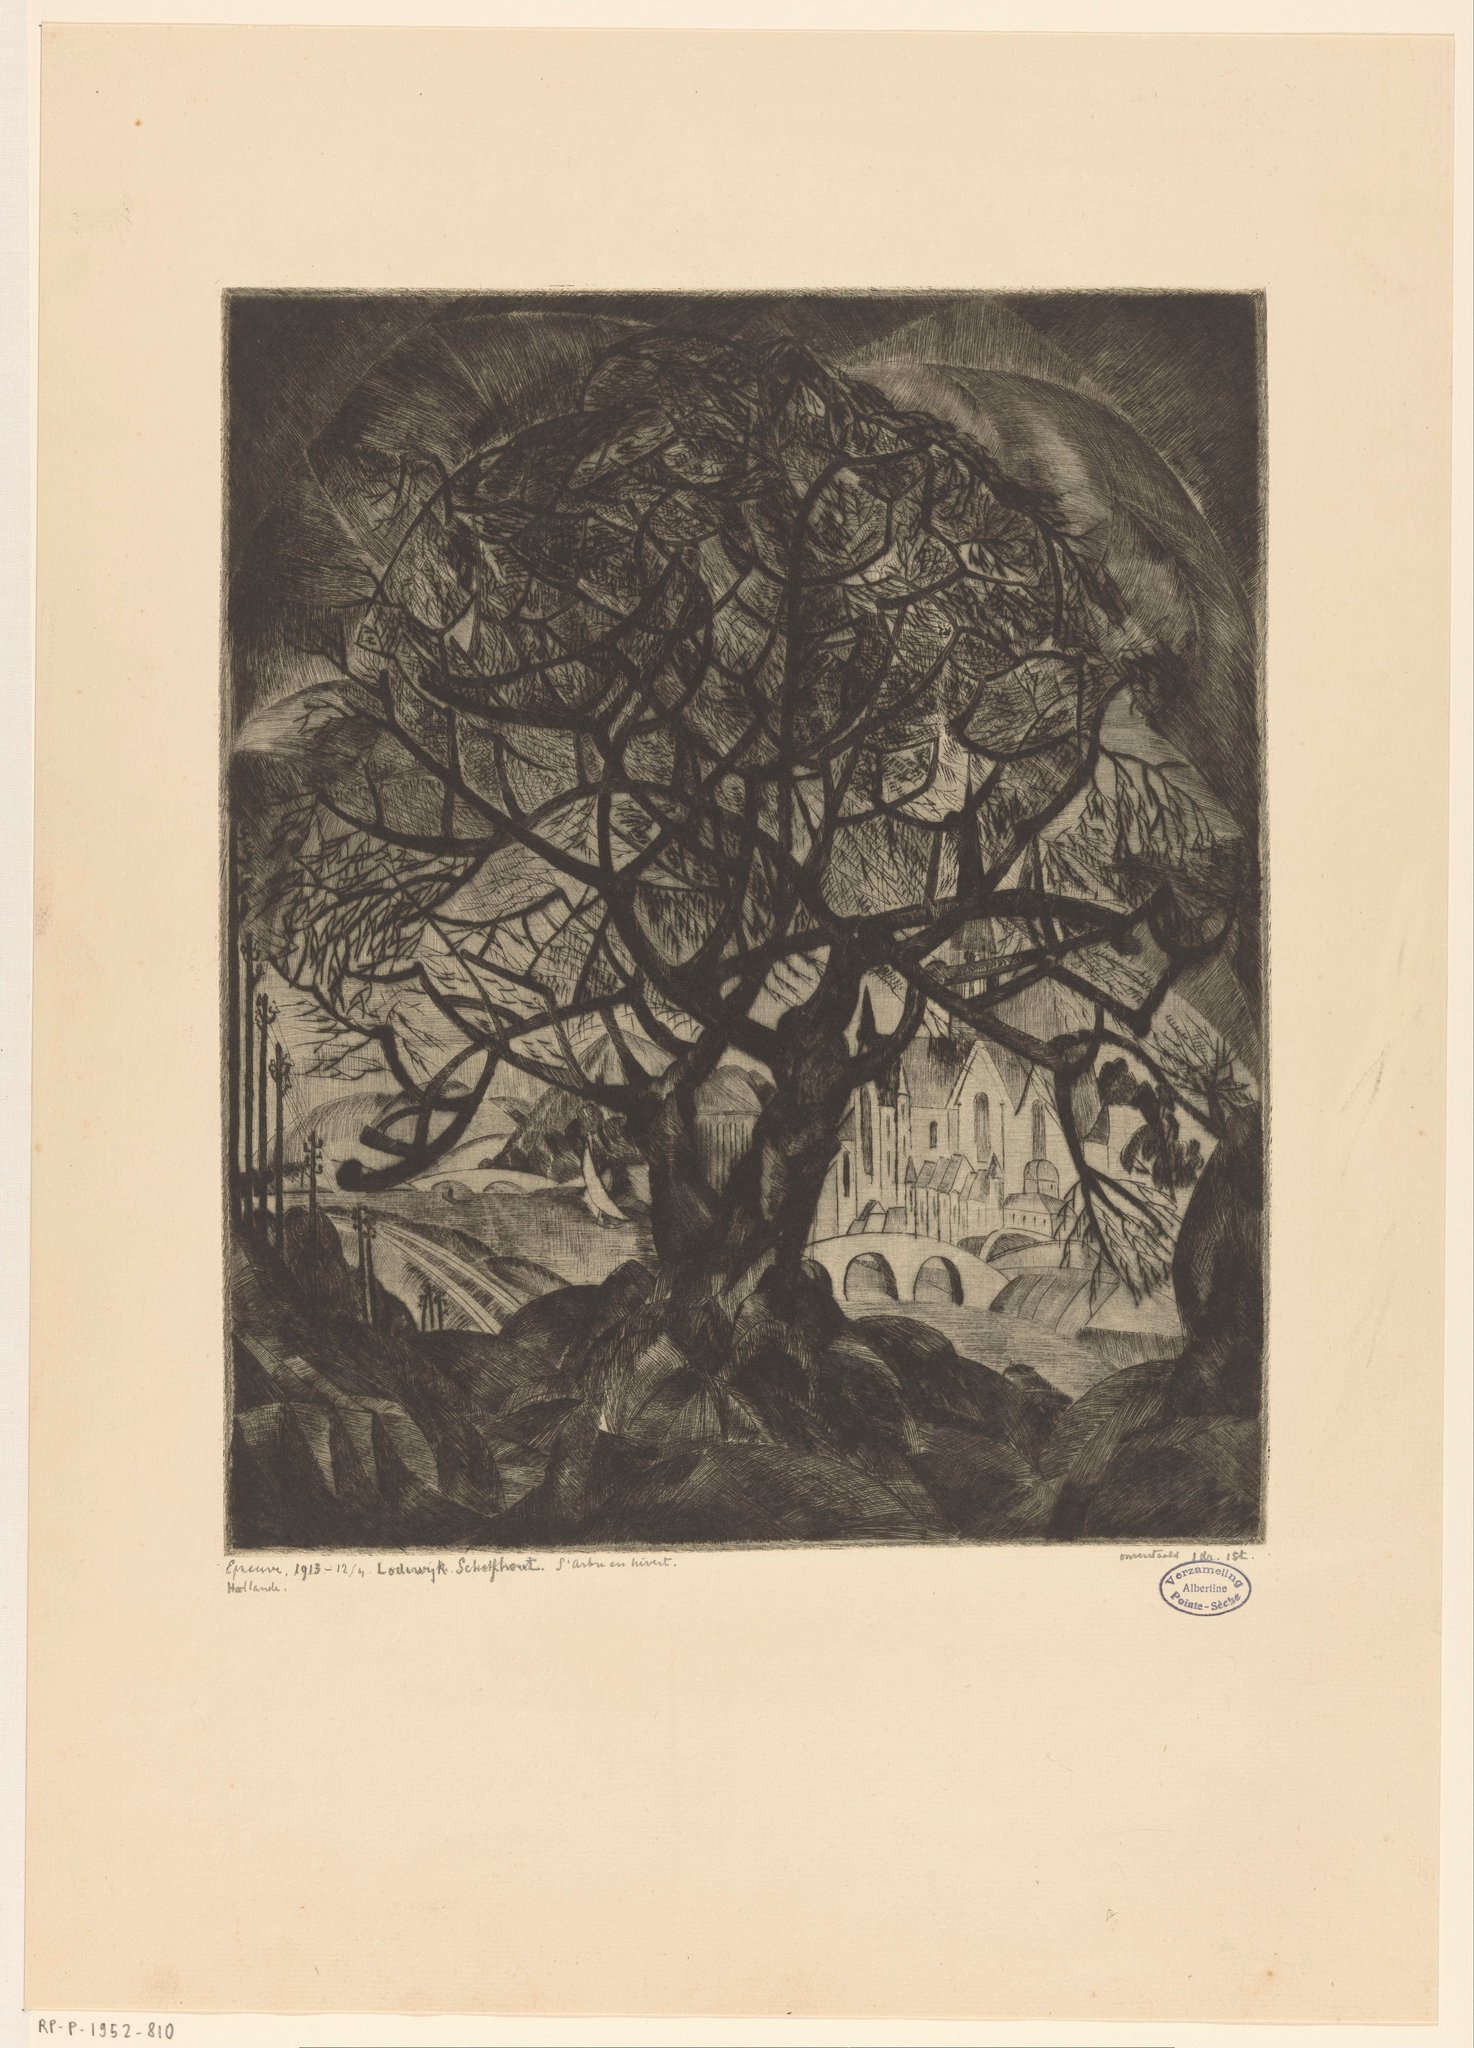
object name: print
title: Boom met kale takken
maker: lodewijk schelfhout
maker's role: draughtsman, print maker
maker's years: 1881-1943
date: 1913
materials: paper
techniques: drypoint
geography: netherlands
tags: trees (+ bare plant), village, pylons, power lines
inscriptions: collector's mark: Lugt 2228, collector's mark: Lugt 5i, collector's mark: Lugt 2760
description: Op de achtergrond een heuvellandschap met elektriciteitsmasten, een meer, bruggen en een nederzetting met kerk.